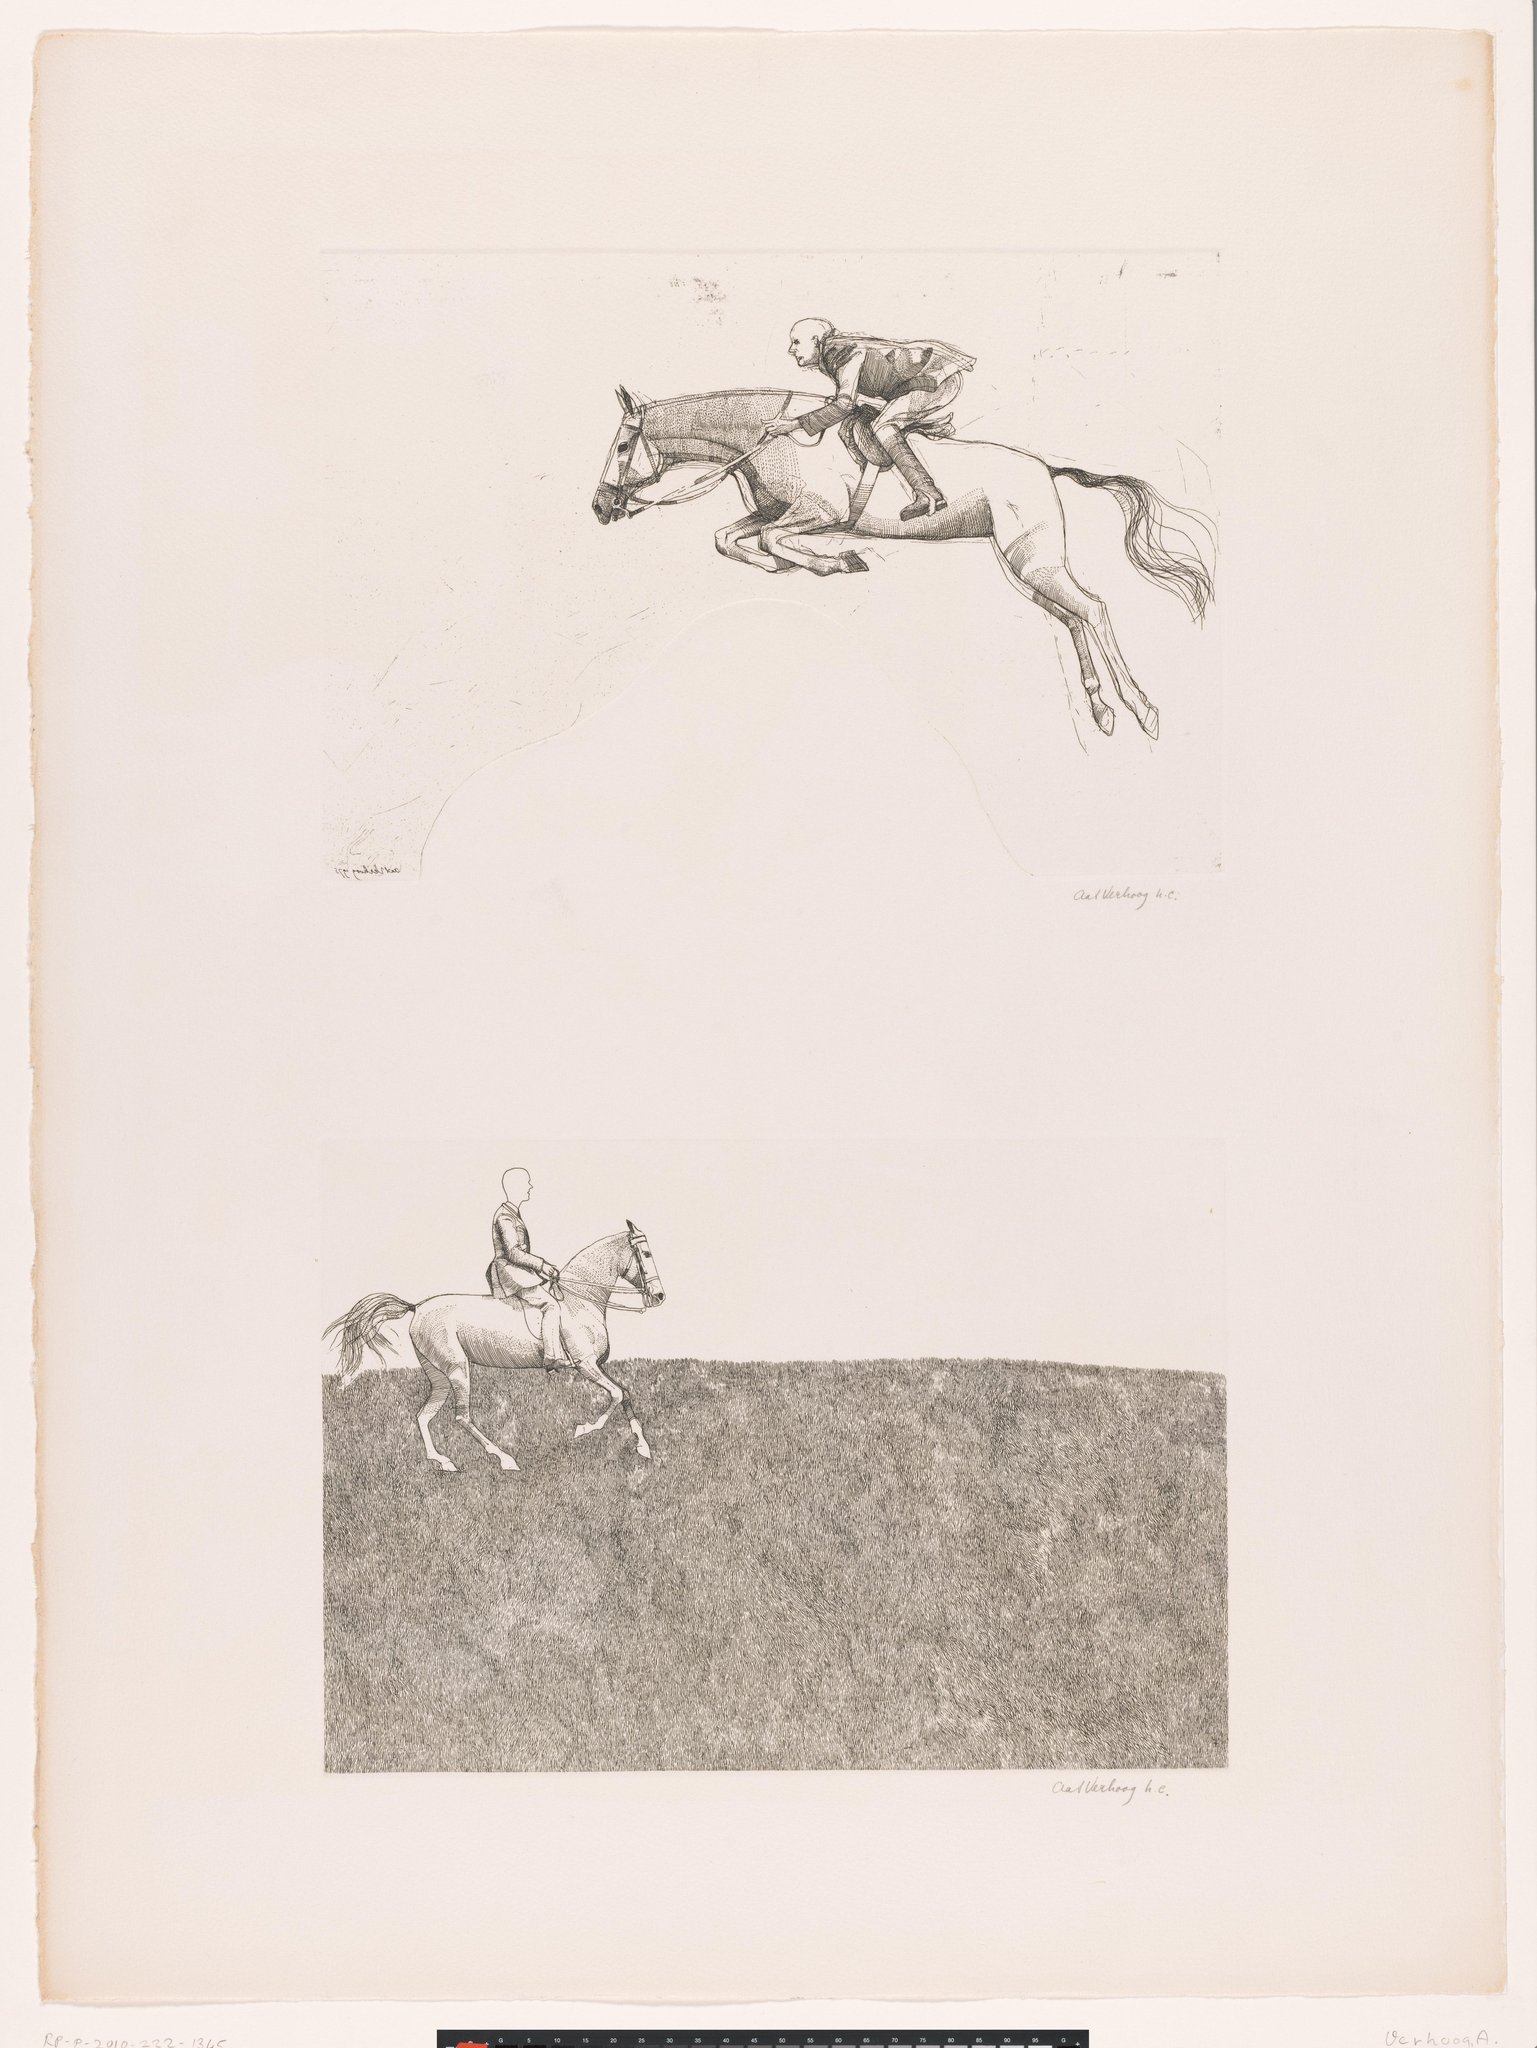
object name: print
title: Springend en galloperend paard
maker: aat verhoog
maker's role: print maker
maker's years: 1933-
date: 1965-1980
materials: paper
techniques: etching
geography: amsterdam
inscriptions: edition: ‘h.c.’, signature: ‘Aat Verhoog’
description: Springend (boven) en galloperend paard (onder) met ruiter.